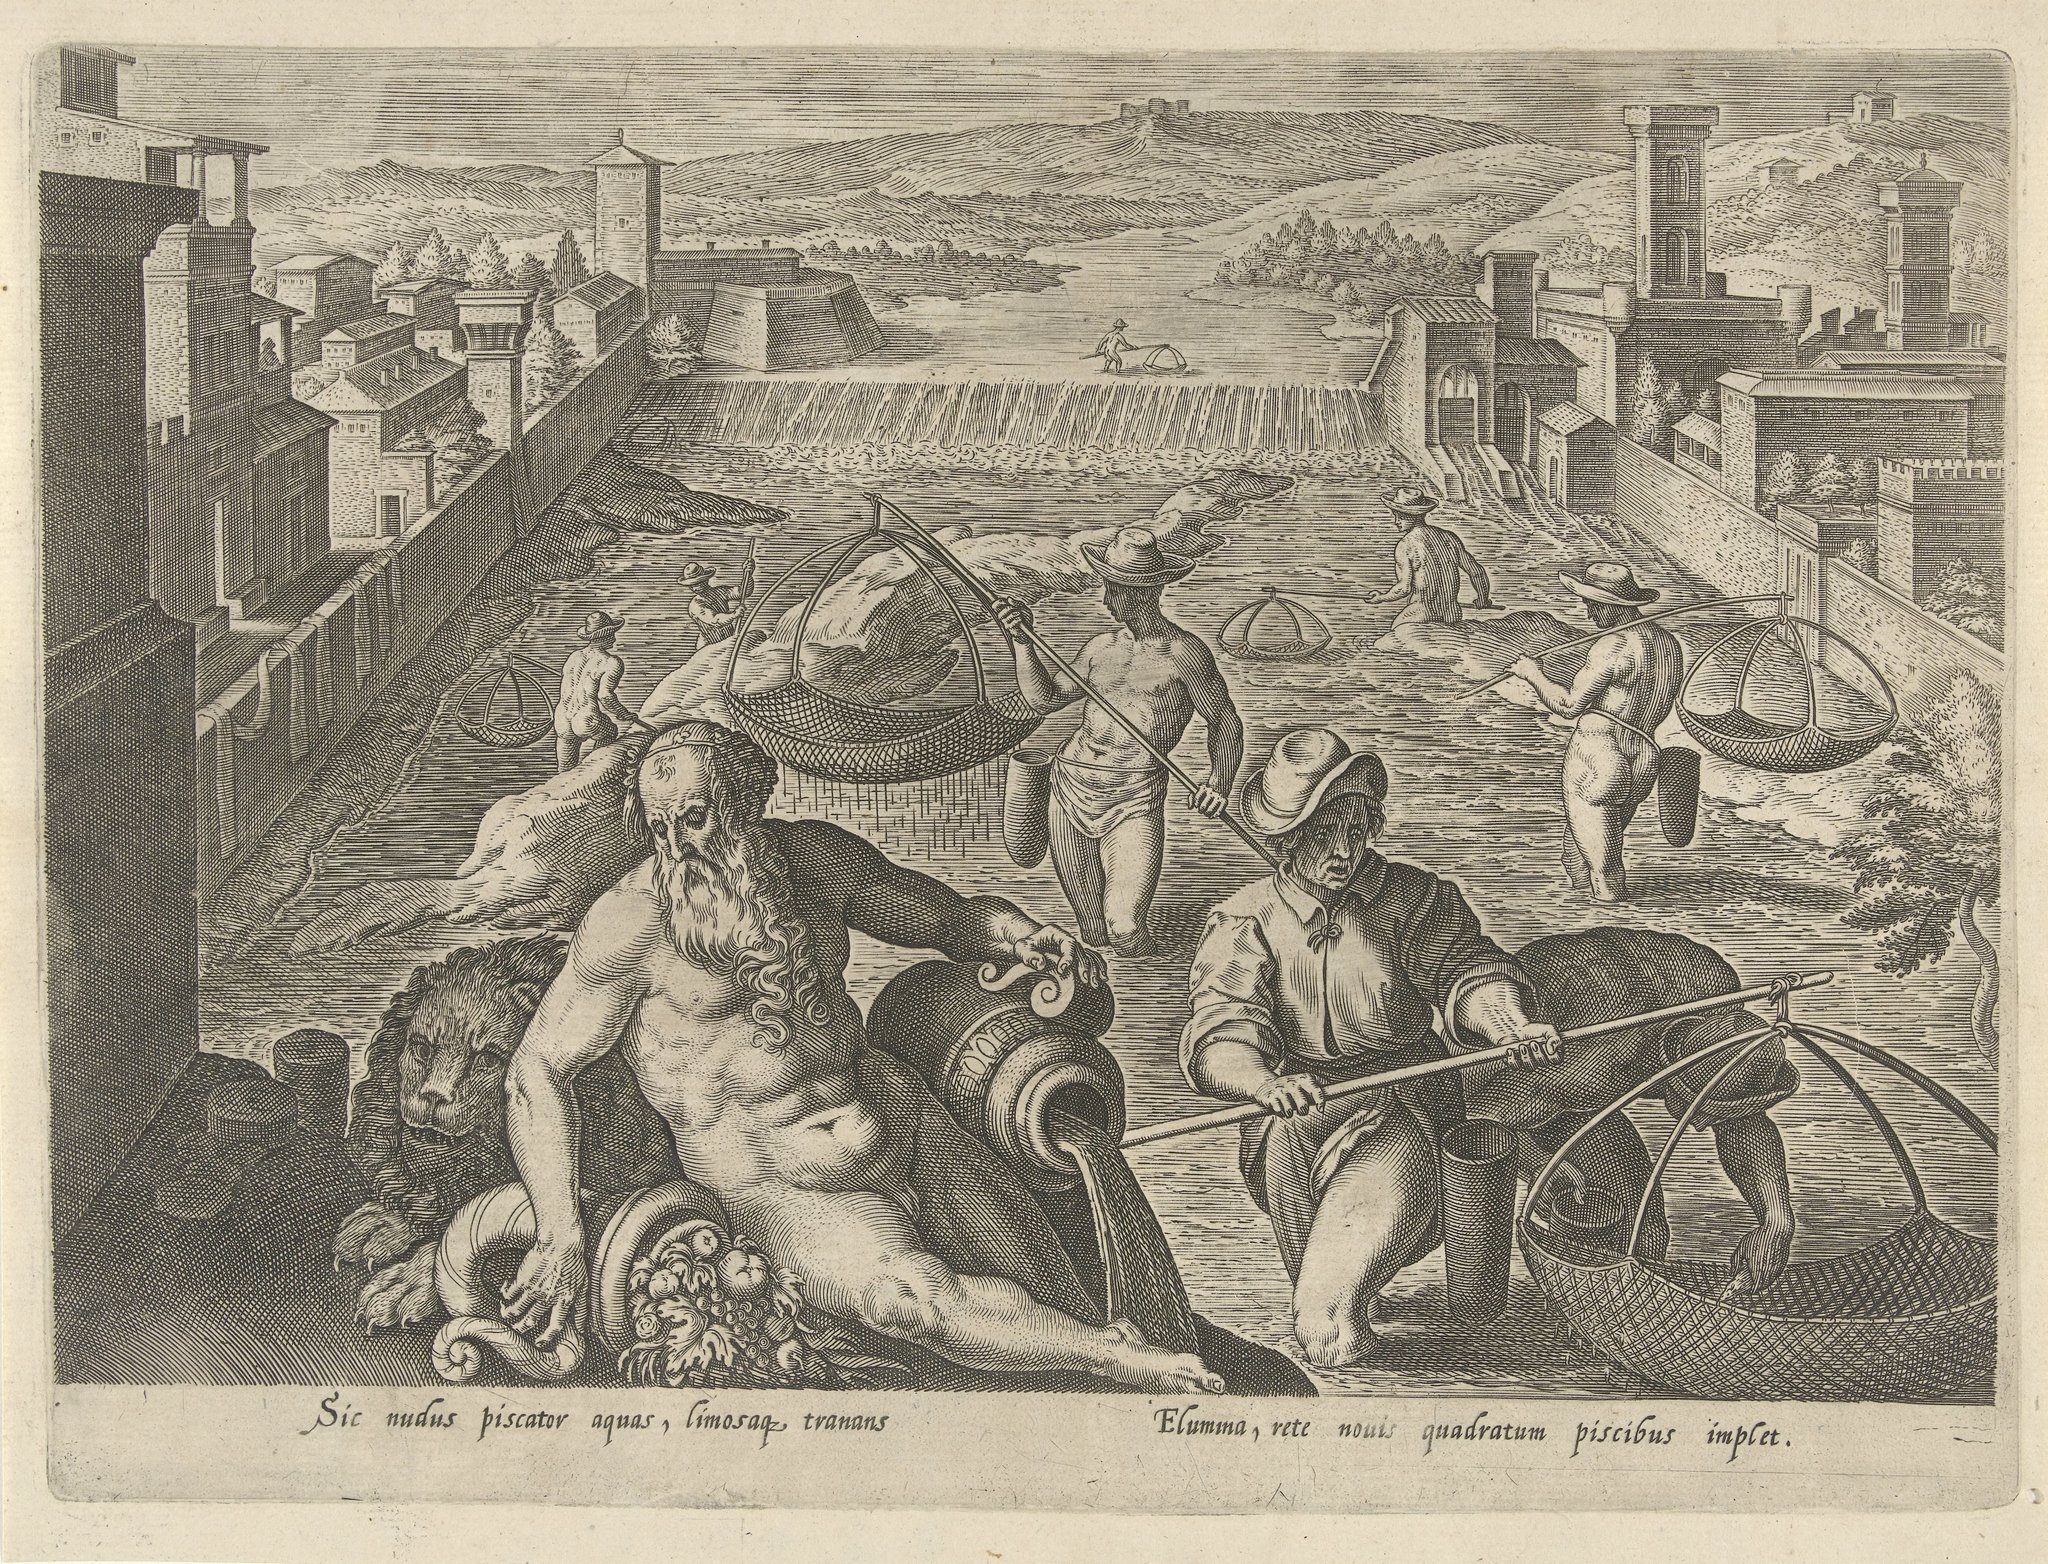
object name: print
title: Visvangst met bolvormig net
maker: philips galle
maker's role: print maker, publisher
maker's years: 1537-1612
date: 1578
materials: paper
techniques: engraving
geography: antwerp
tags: fresh-water fishery (+ aids ~ crafts, industries, agriculture)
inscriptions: collector's mark: Lugt 2228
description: In een rivier wordt vis gevangen door middel van een bolvormig net. De prent heeft een Latijns onderschrift en maakt deel uit van een 43-delige serie over de jacht.